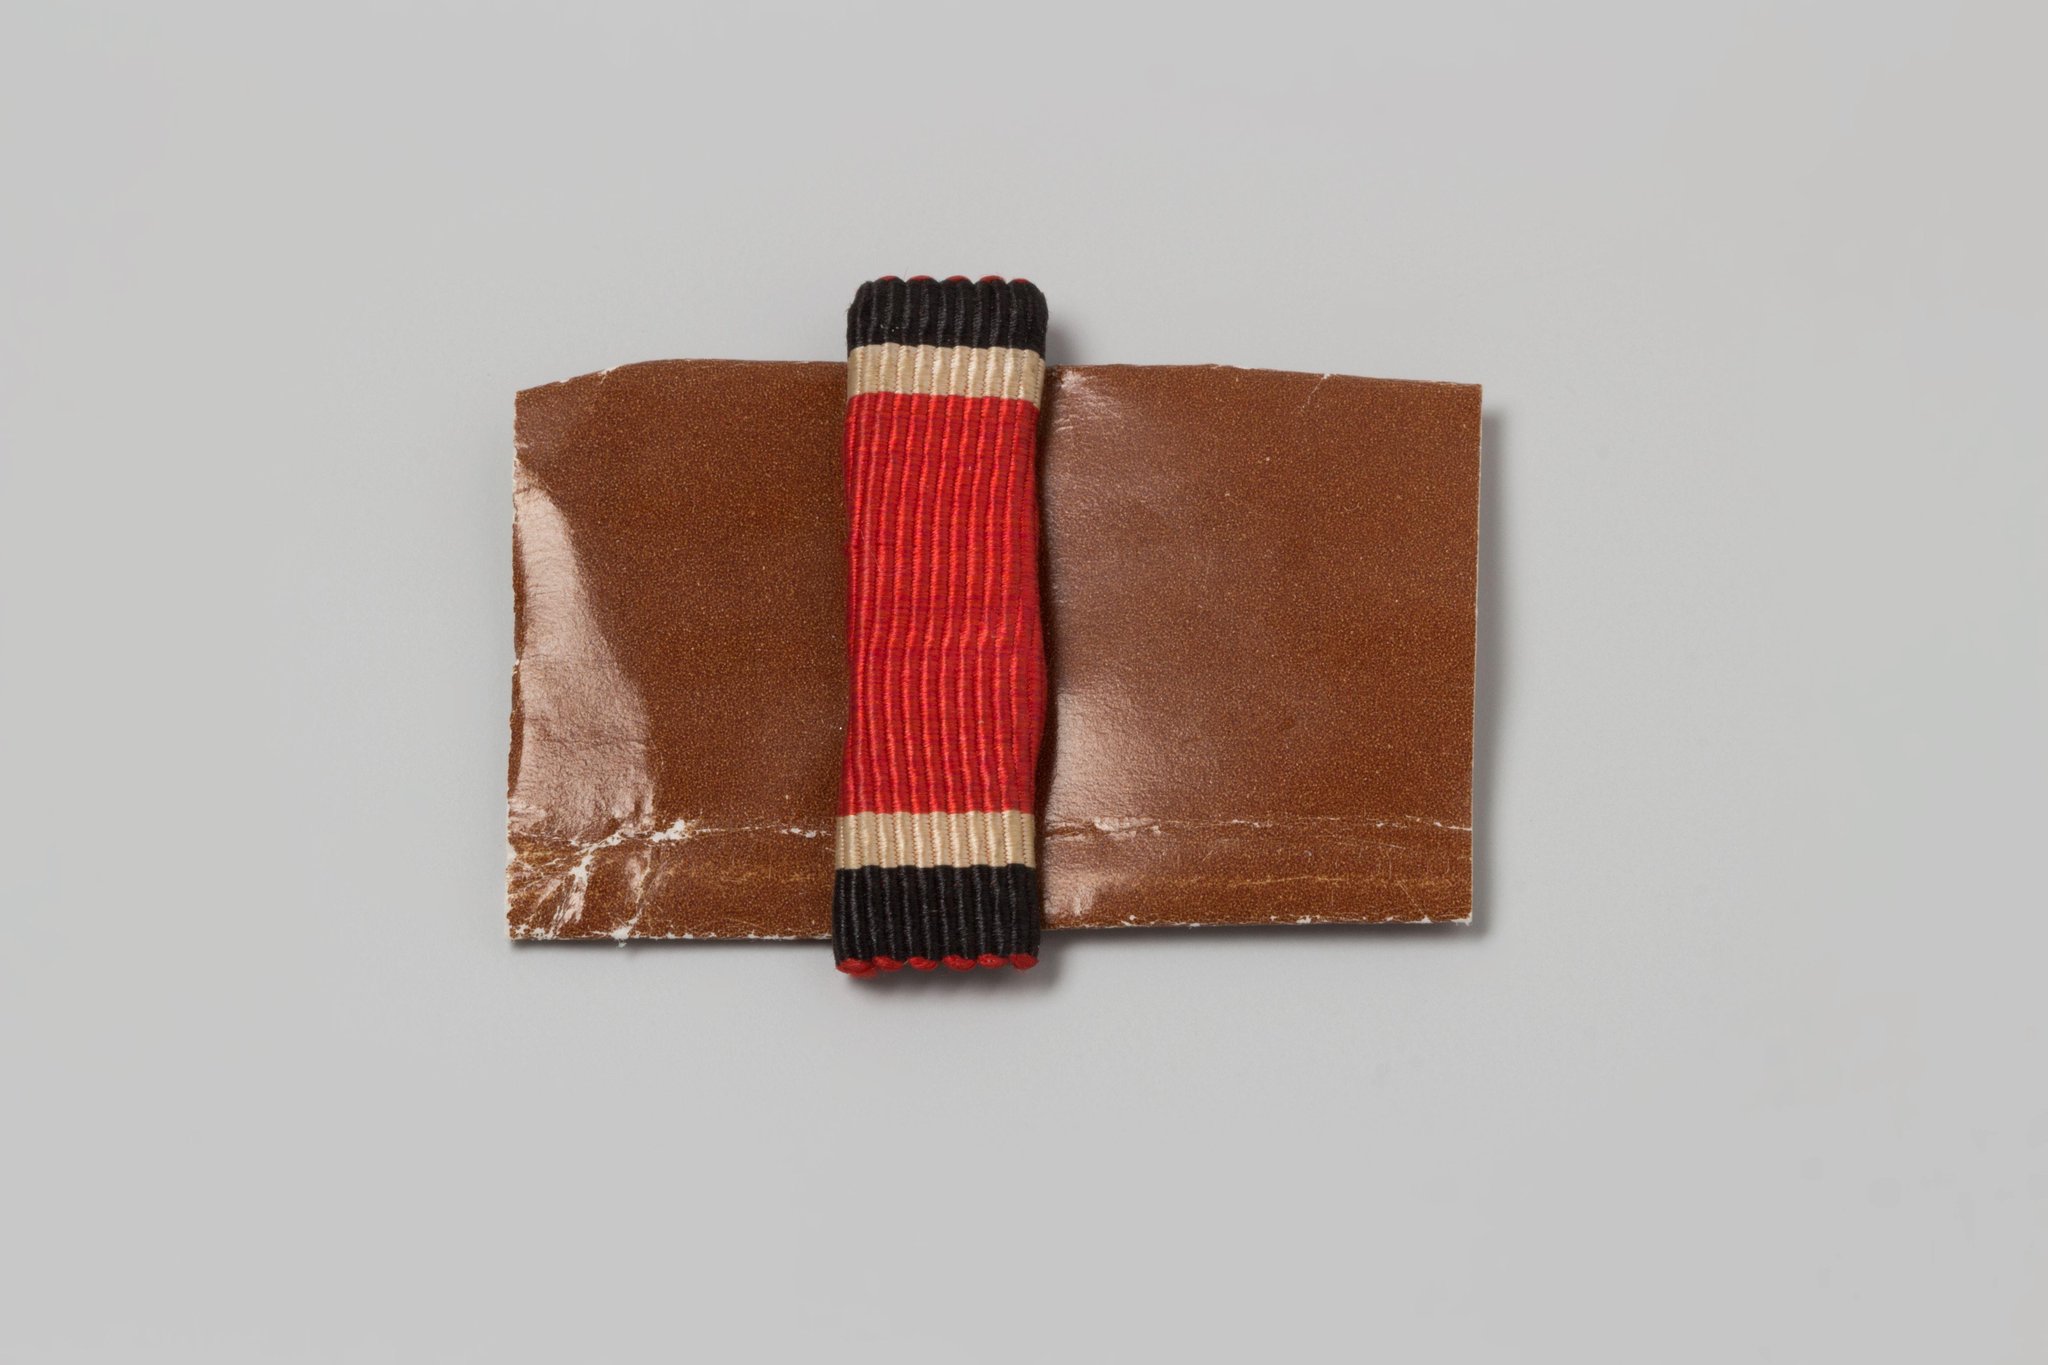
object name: ordelint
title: Gestreept lint van breed rood tussen wit en zwarte biezen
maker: Anonymous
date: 1900-1925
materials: metal, silk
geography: western europe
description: Gestreept lint van breed rood tussen wit en zwarte biezen. Mogelijk daags ordelint van Légion d'Honneur.